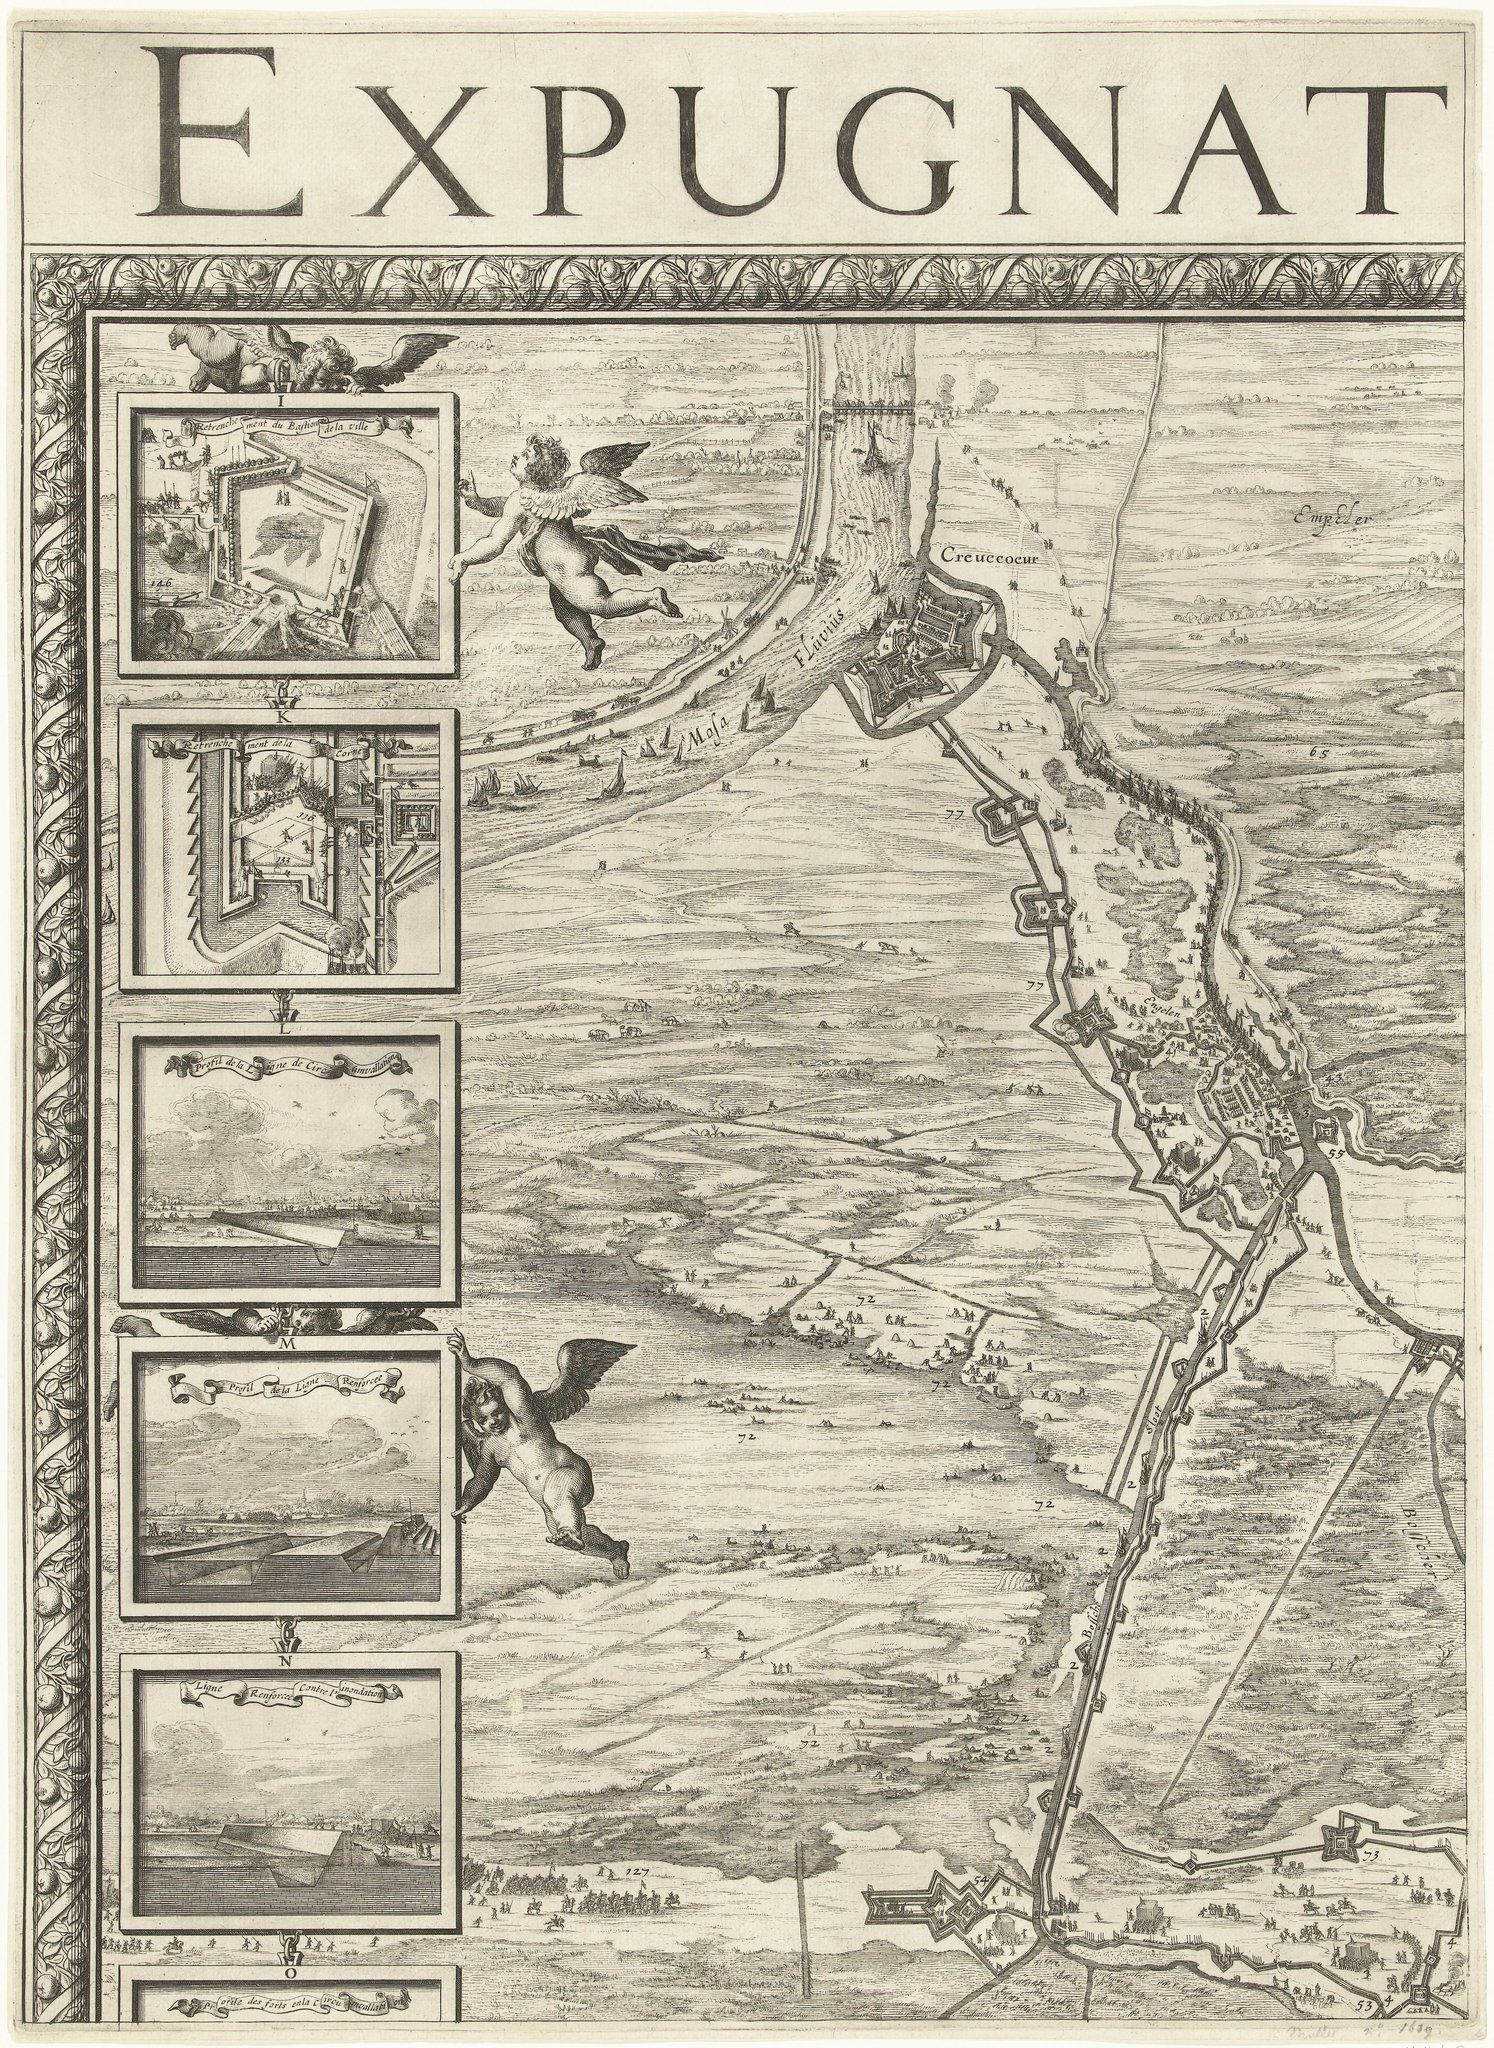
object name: map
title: Expugnatio Sylvae-Ducis Ao 1629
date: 1629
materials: paper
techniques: etching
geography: northern netherlands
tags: delft, frederick henry (prince of orange), maps of separate countries or regions, siege, position war, den bosch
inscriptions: collector's mark: Lugt 2228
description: Grote kaart van het beleg van Den Bosch door het Staatse leger onder Frederik Hendrik, van 1 mei tot 17 september 1629. Aan weerszijden van de kaart 18 kleine voorstellingen met details van de versterkingen van de stad en omliggende forten gemerkt I-Z. Kaart samengesteld uit zes platen en twee - ontbrekende - tekstbladen. Dit is het blad linksboven met een deel van de kaart met Crevecoeur en een deel van de omsingeling.